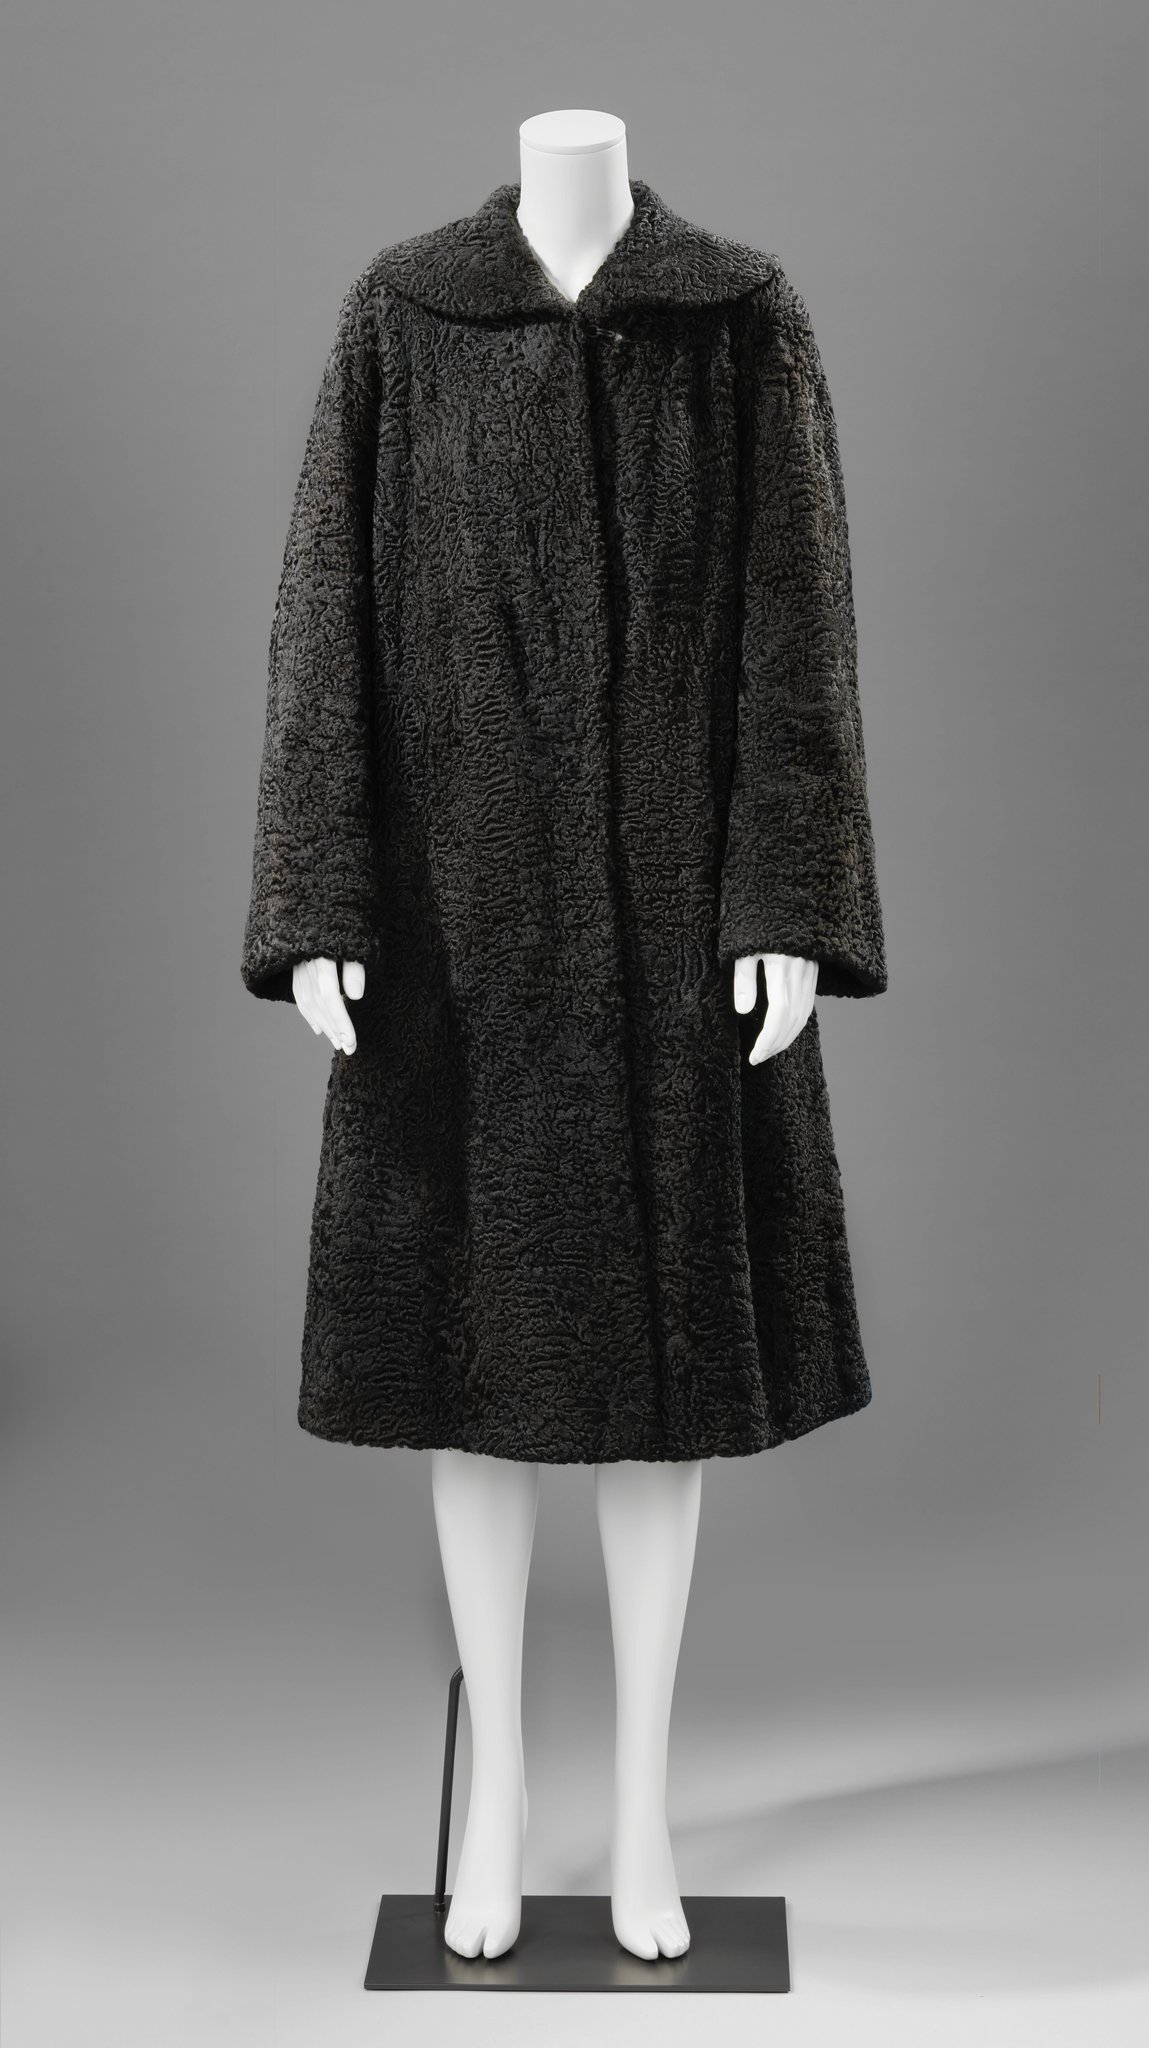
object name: womenswear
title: Calf-Length Fur Coat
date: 1950-1960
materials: fur, silk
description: The pelt of Karakul lambs stays curly for only a few days after birth. To obtain astrakhan fur the lambs therefore have to be slaughtered while they are still very young. This coat was made by the Splitter frères fur goods firm, which altered their ready-to-wear coats to their clients’ own measurements.